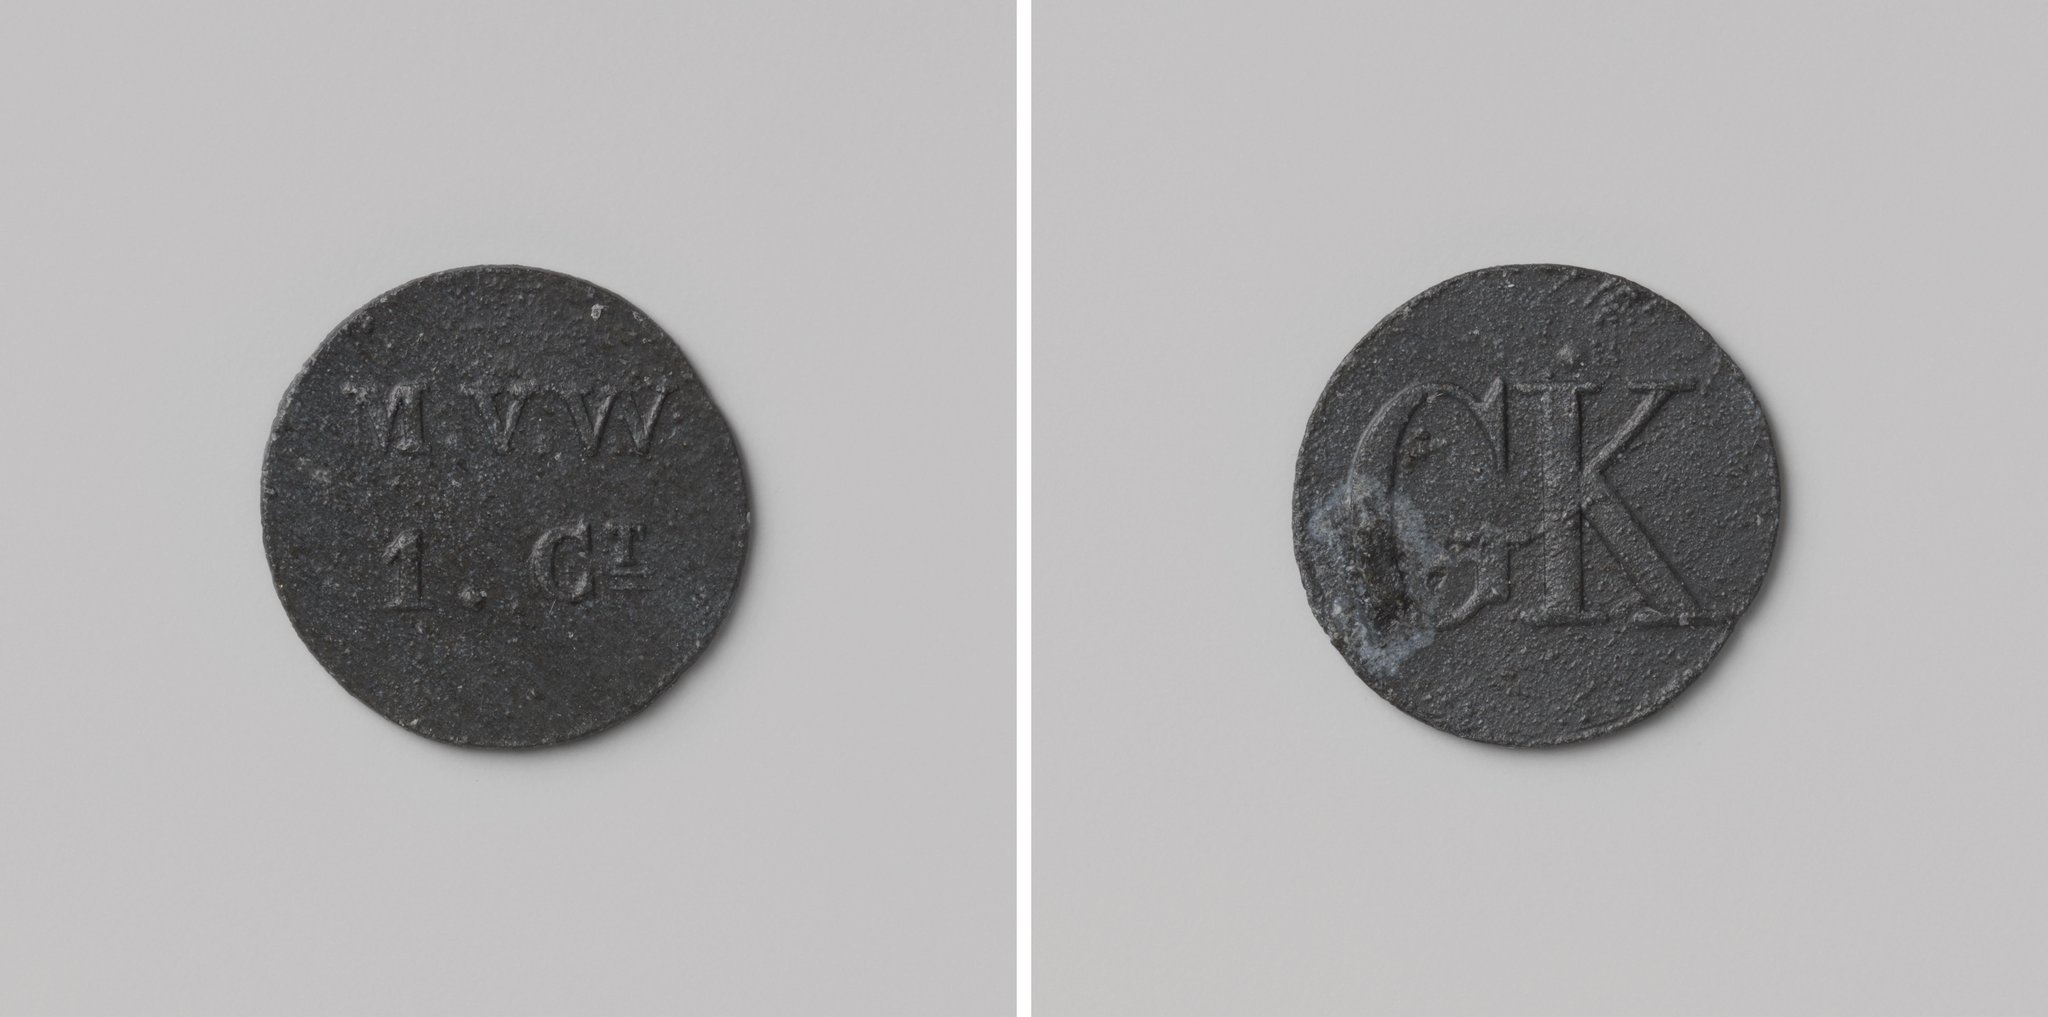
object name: cent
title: Huismunt geslagen op last van de Maatschappij van Weldadigheid ter waarde van 1 cent, ten behoeve van de Gewone Koloniën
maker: Anonymous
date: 1818-1859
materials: zinc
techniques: striking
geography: netherlands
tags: maatschappij van weldadigheid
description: Zinken munt. Voorzijde: opschrift boven waardeaanduiding. Keerzijde: opschrift G en K